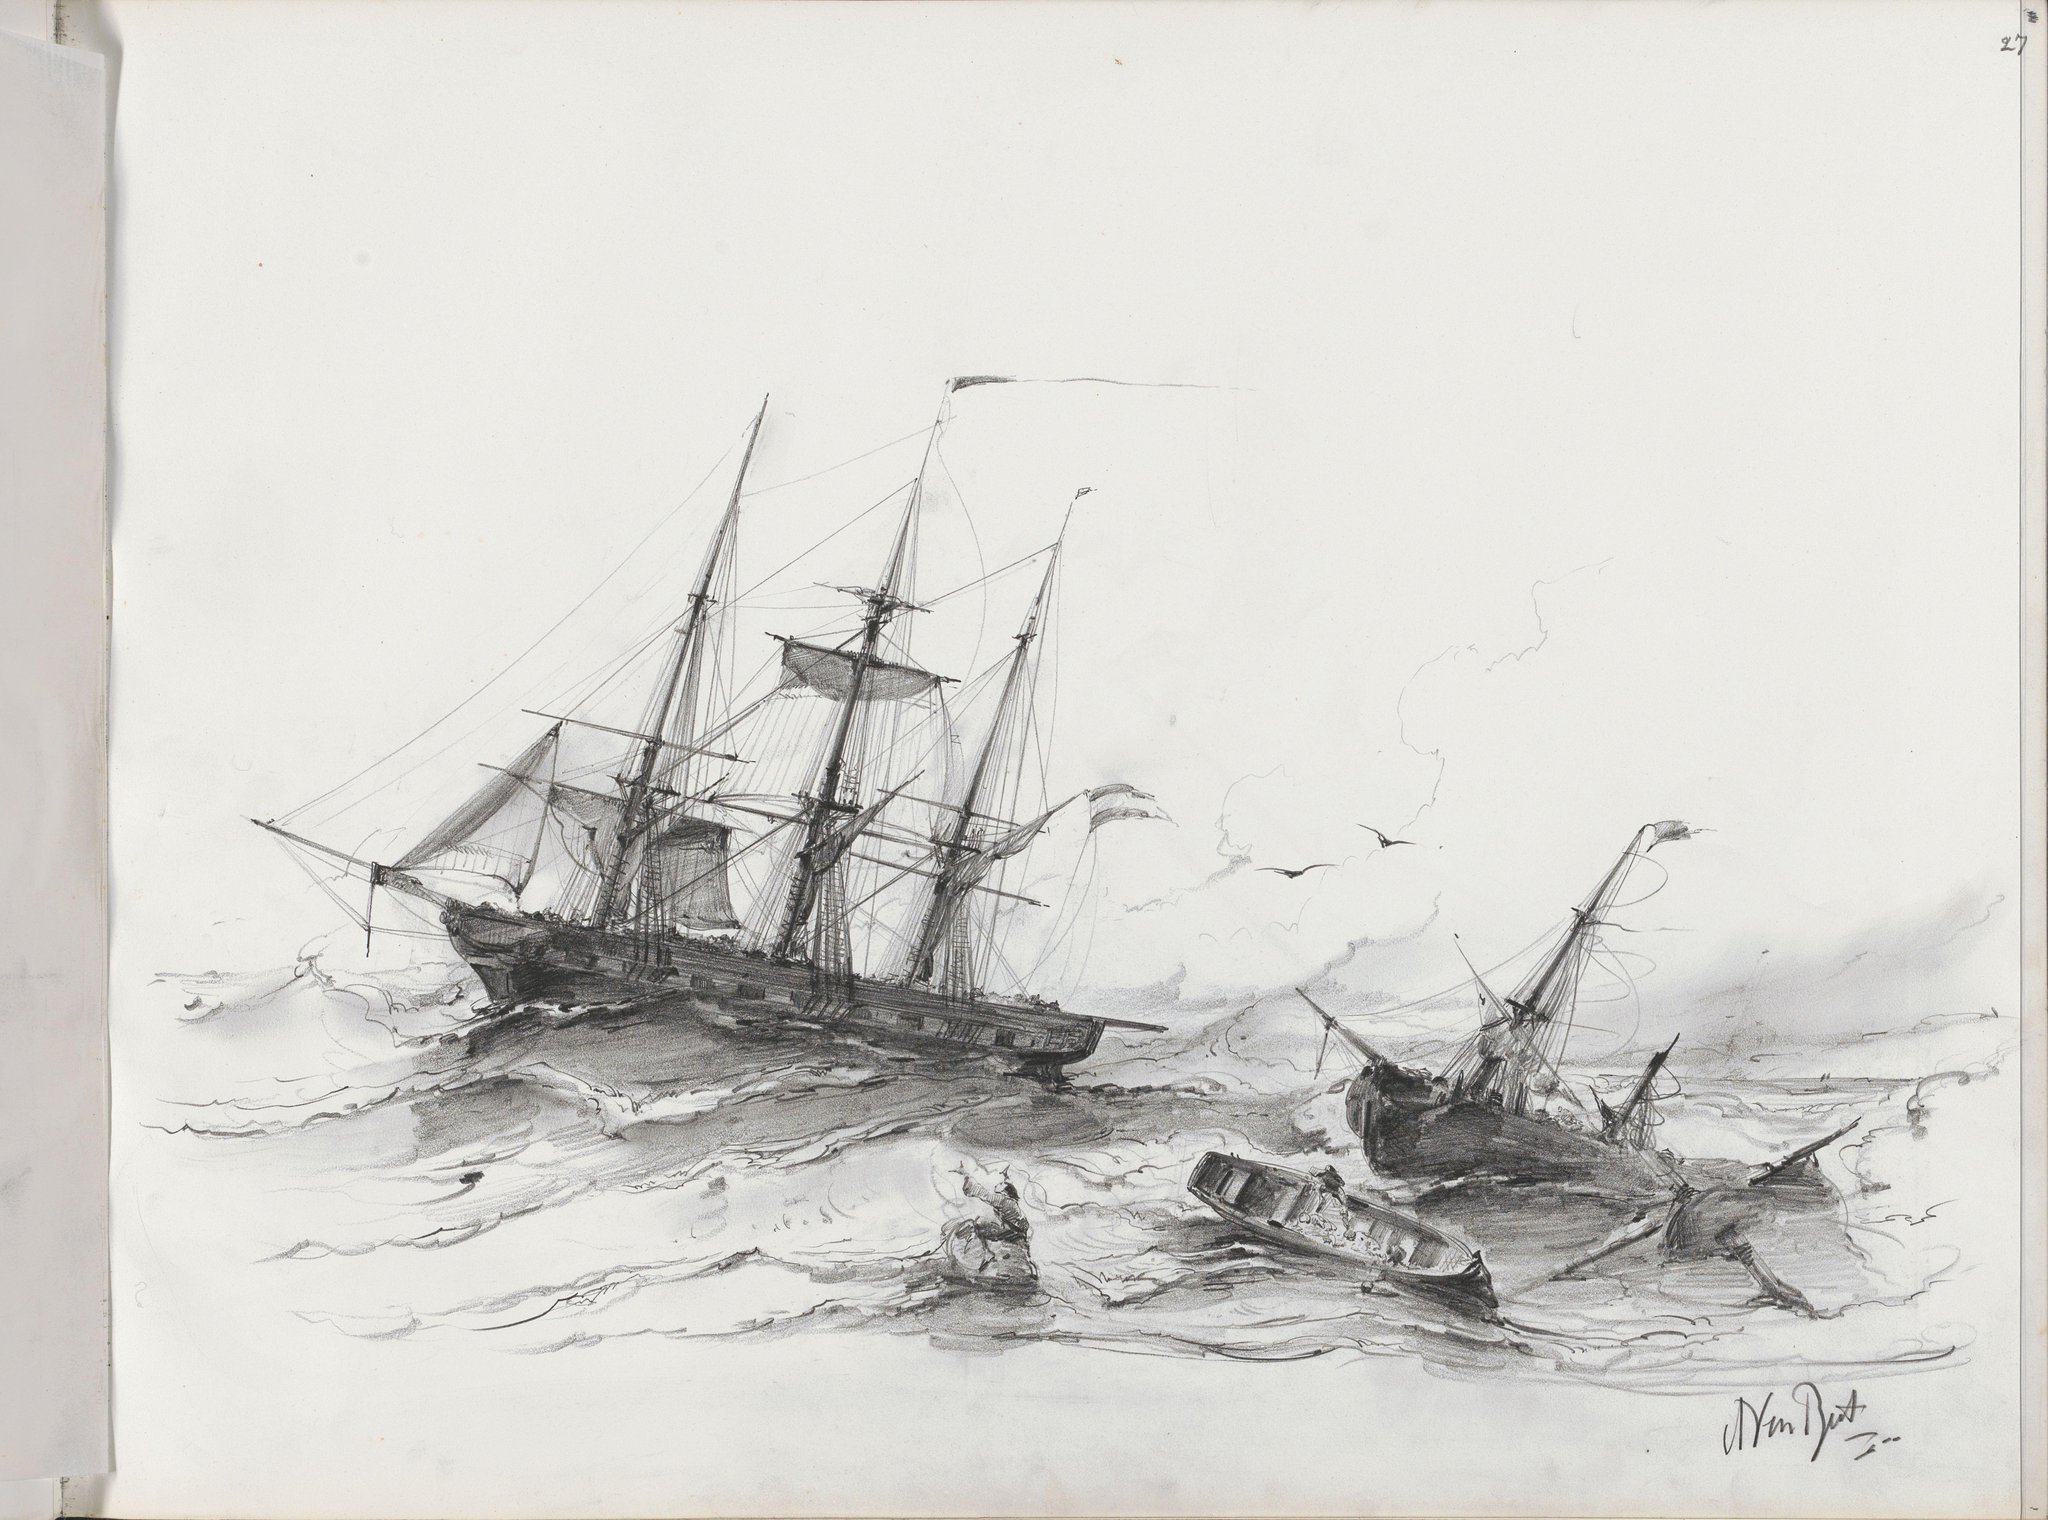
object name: sketchbook leaf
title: Schipbreuk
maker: albertus van beest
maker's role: draughtsman, print maker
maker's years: 1820-1860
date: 1830-1860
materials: paper, pencil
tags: sailing-ship, sailing-boat, lifeboat, shipwreck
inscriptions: signature: ‘A Van Beest.’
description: Op de voorgrond een grotendeels kapot geslagen schip op een stormachtige zee. Naast het schip een figuur in een reddingsloep en een overlevende op een rots. Deze figuur gebaart met de handen in de lucht naar een passerende driemaster. Blad 27 recto uit een schetsboek met 46 bladen.